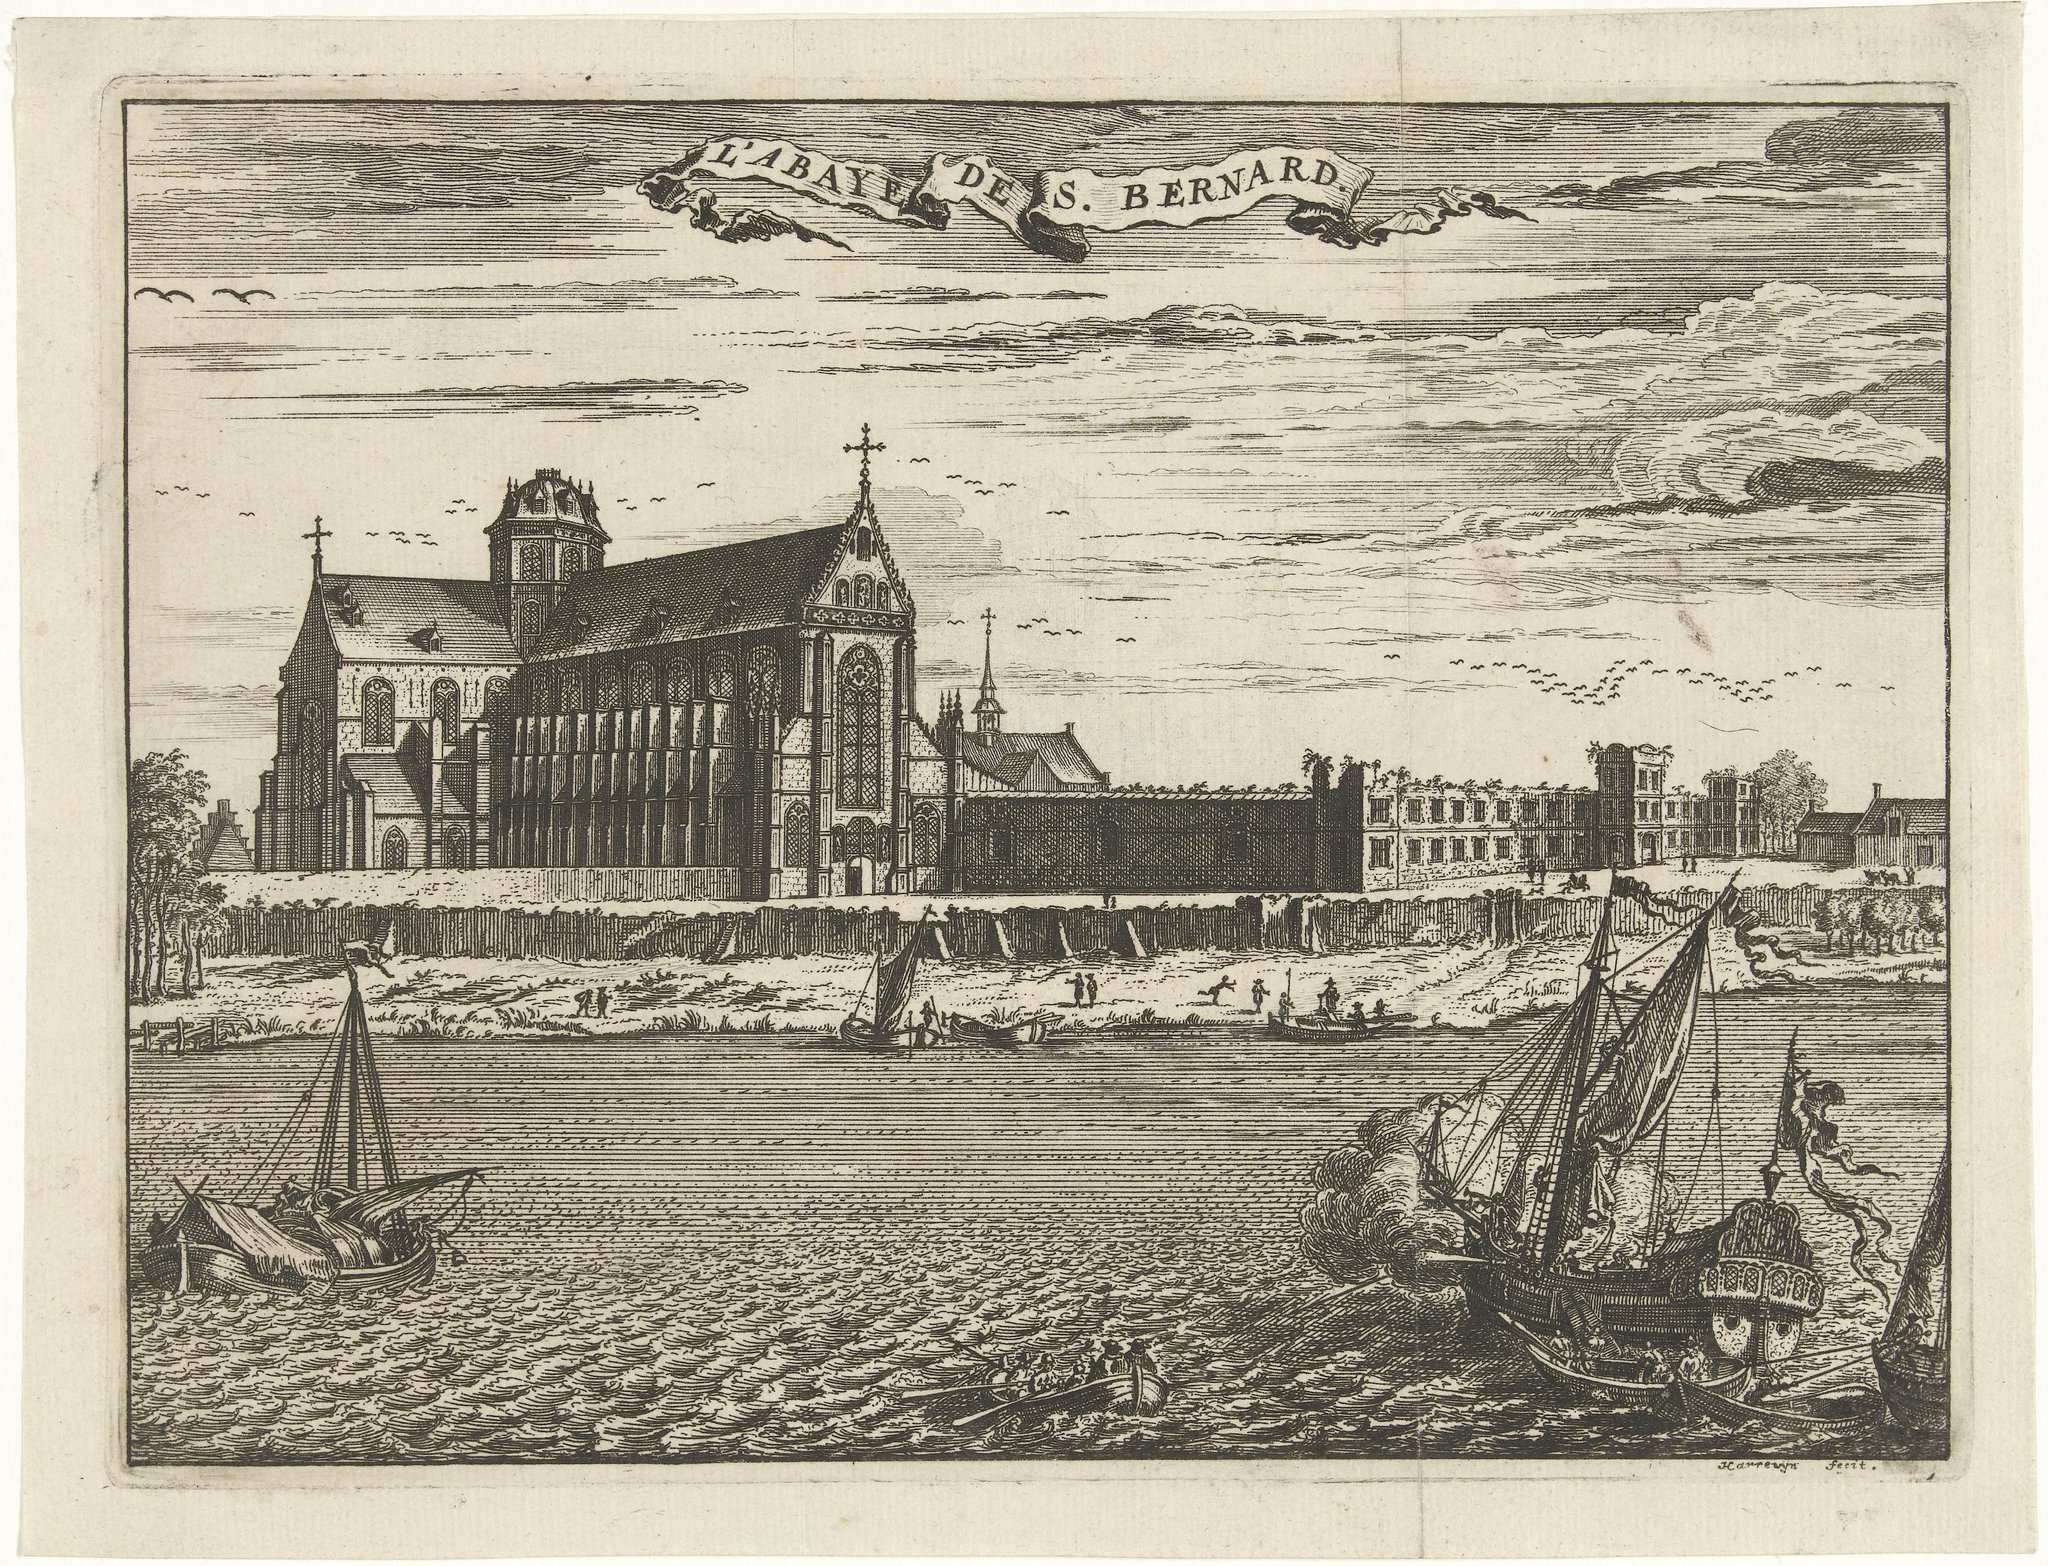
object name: print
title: Sint Bernardusabdij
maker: jacobus harrewijn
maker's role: print maker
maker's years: 1660-1740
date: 1682-1730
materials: paper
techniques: etching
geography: low countries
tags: abbey, monastery, convent ~ roman catholic church, church (exterior), abbey wall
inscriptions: collector's mark: Lugt 2228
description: Gezicht op een kerk en de muren van een abdij aan een waterkant. Bovenaan de titel op een lint.